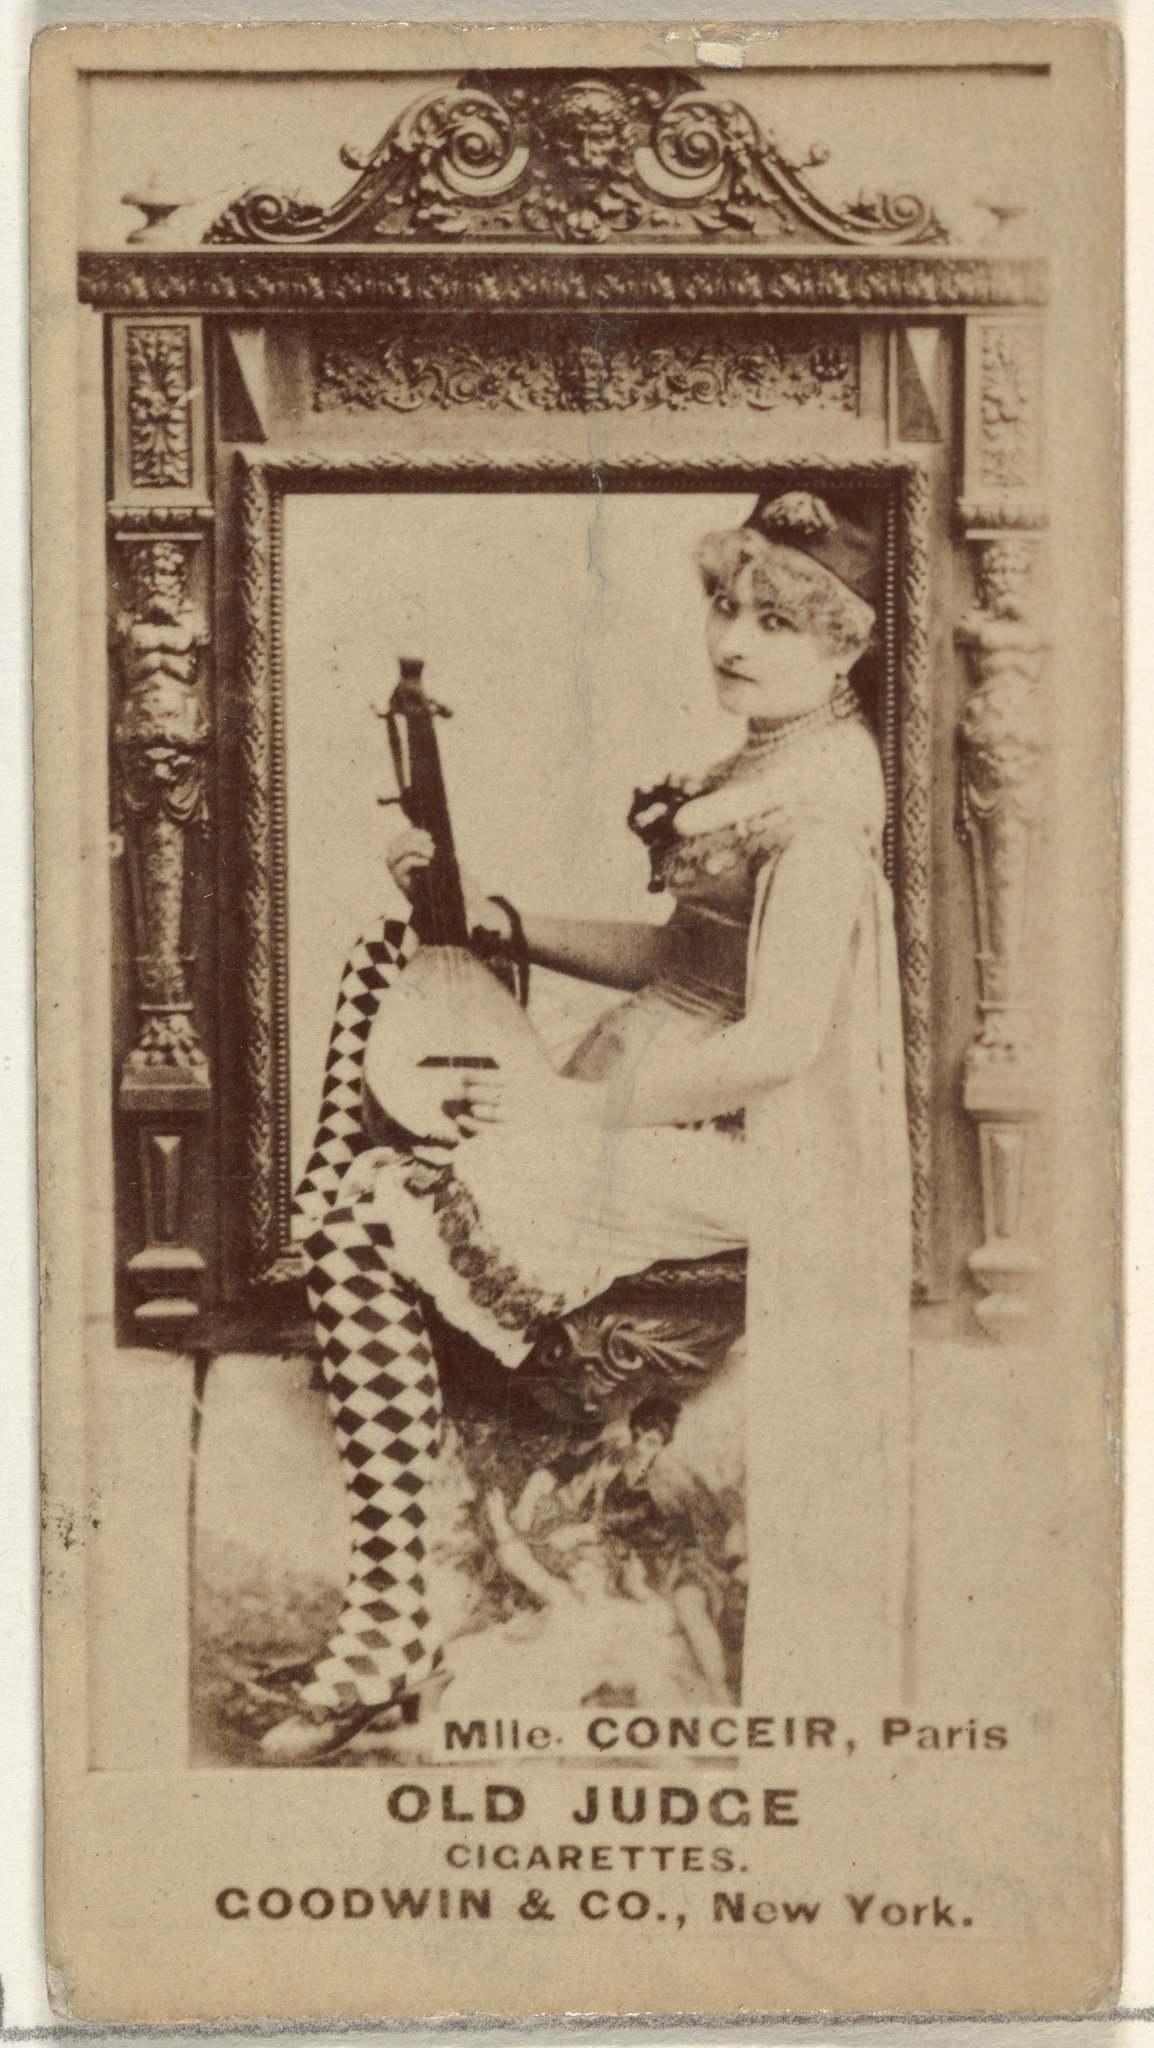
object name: photograph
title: Mlle. Conceir, Paris, from the Actors and Actresses series (N171) for Old Judge Cigarettes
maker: goodwin & company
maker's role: publisher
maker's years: 1850-1950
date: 1886-1890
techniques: albumen silver print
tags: musical instruments,portraits,women,actresses